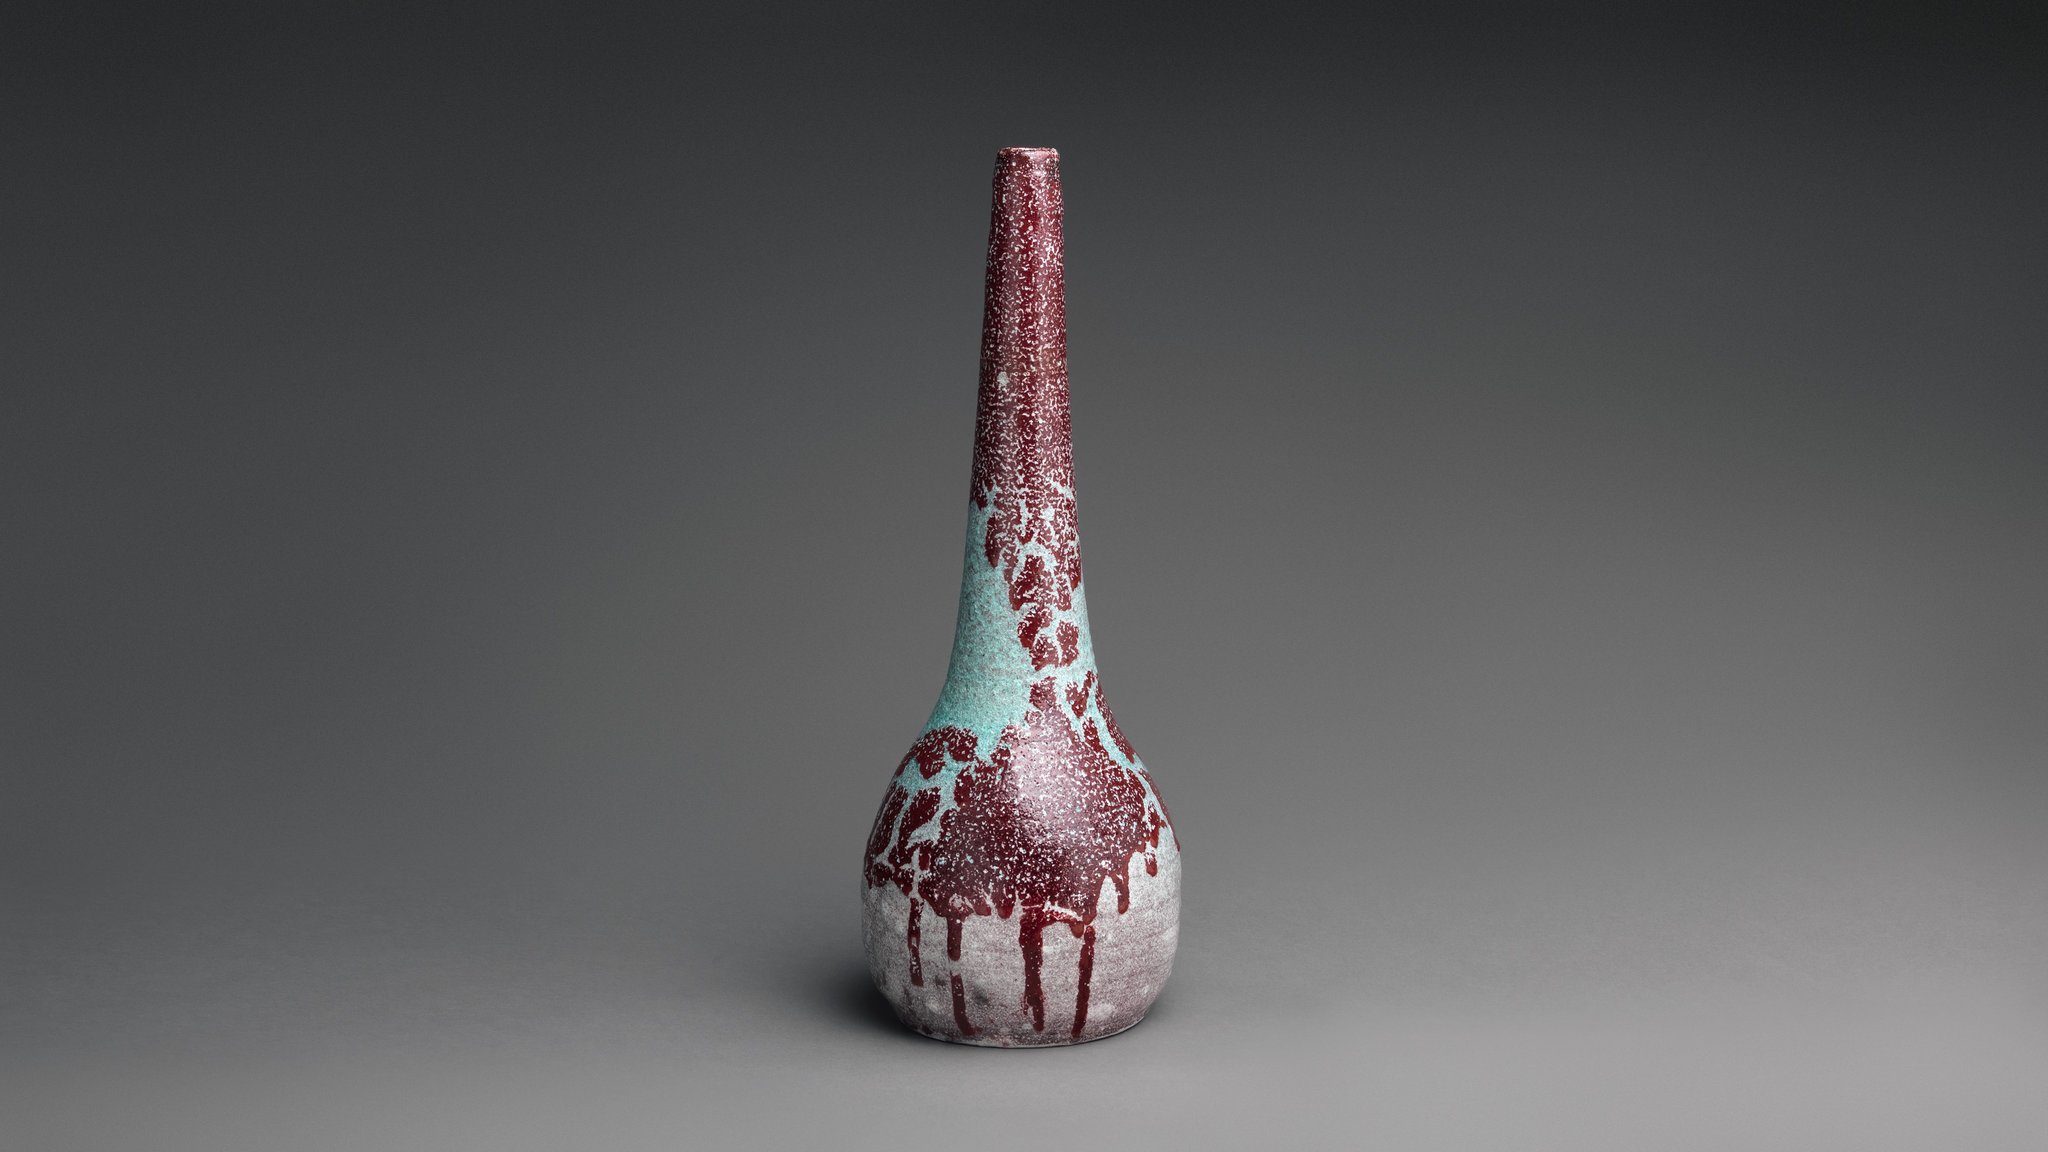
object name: vase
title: Bottle vase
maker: ernest chaplet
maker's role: maker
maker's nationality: french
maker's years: 1835-1909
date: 1890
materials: porcelain